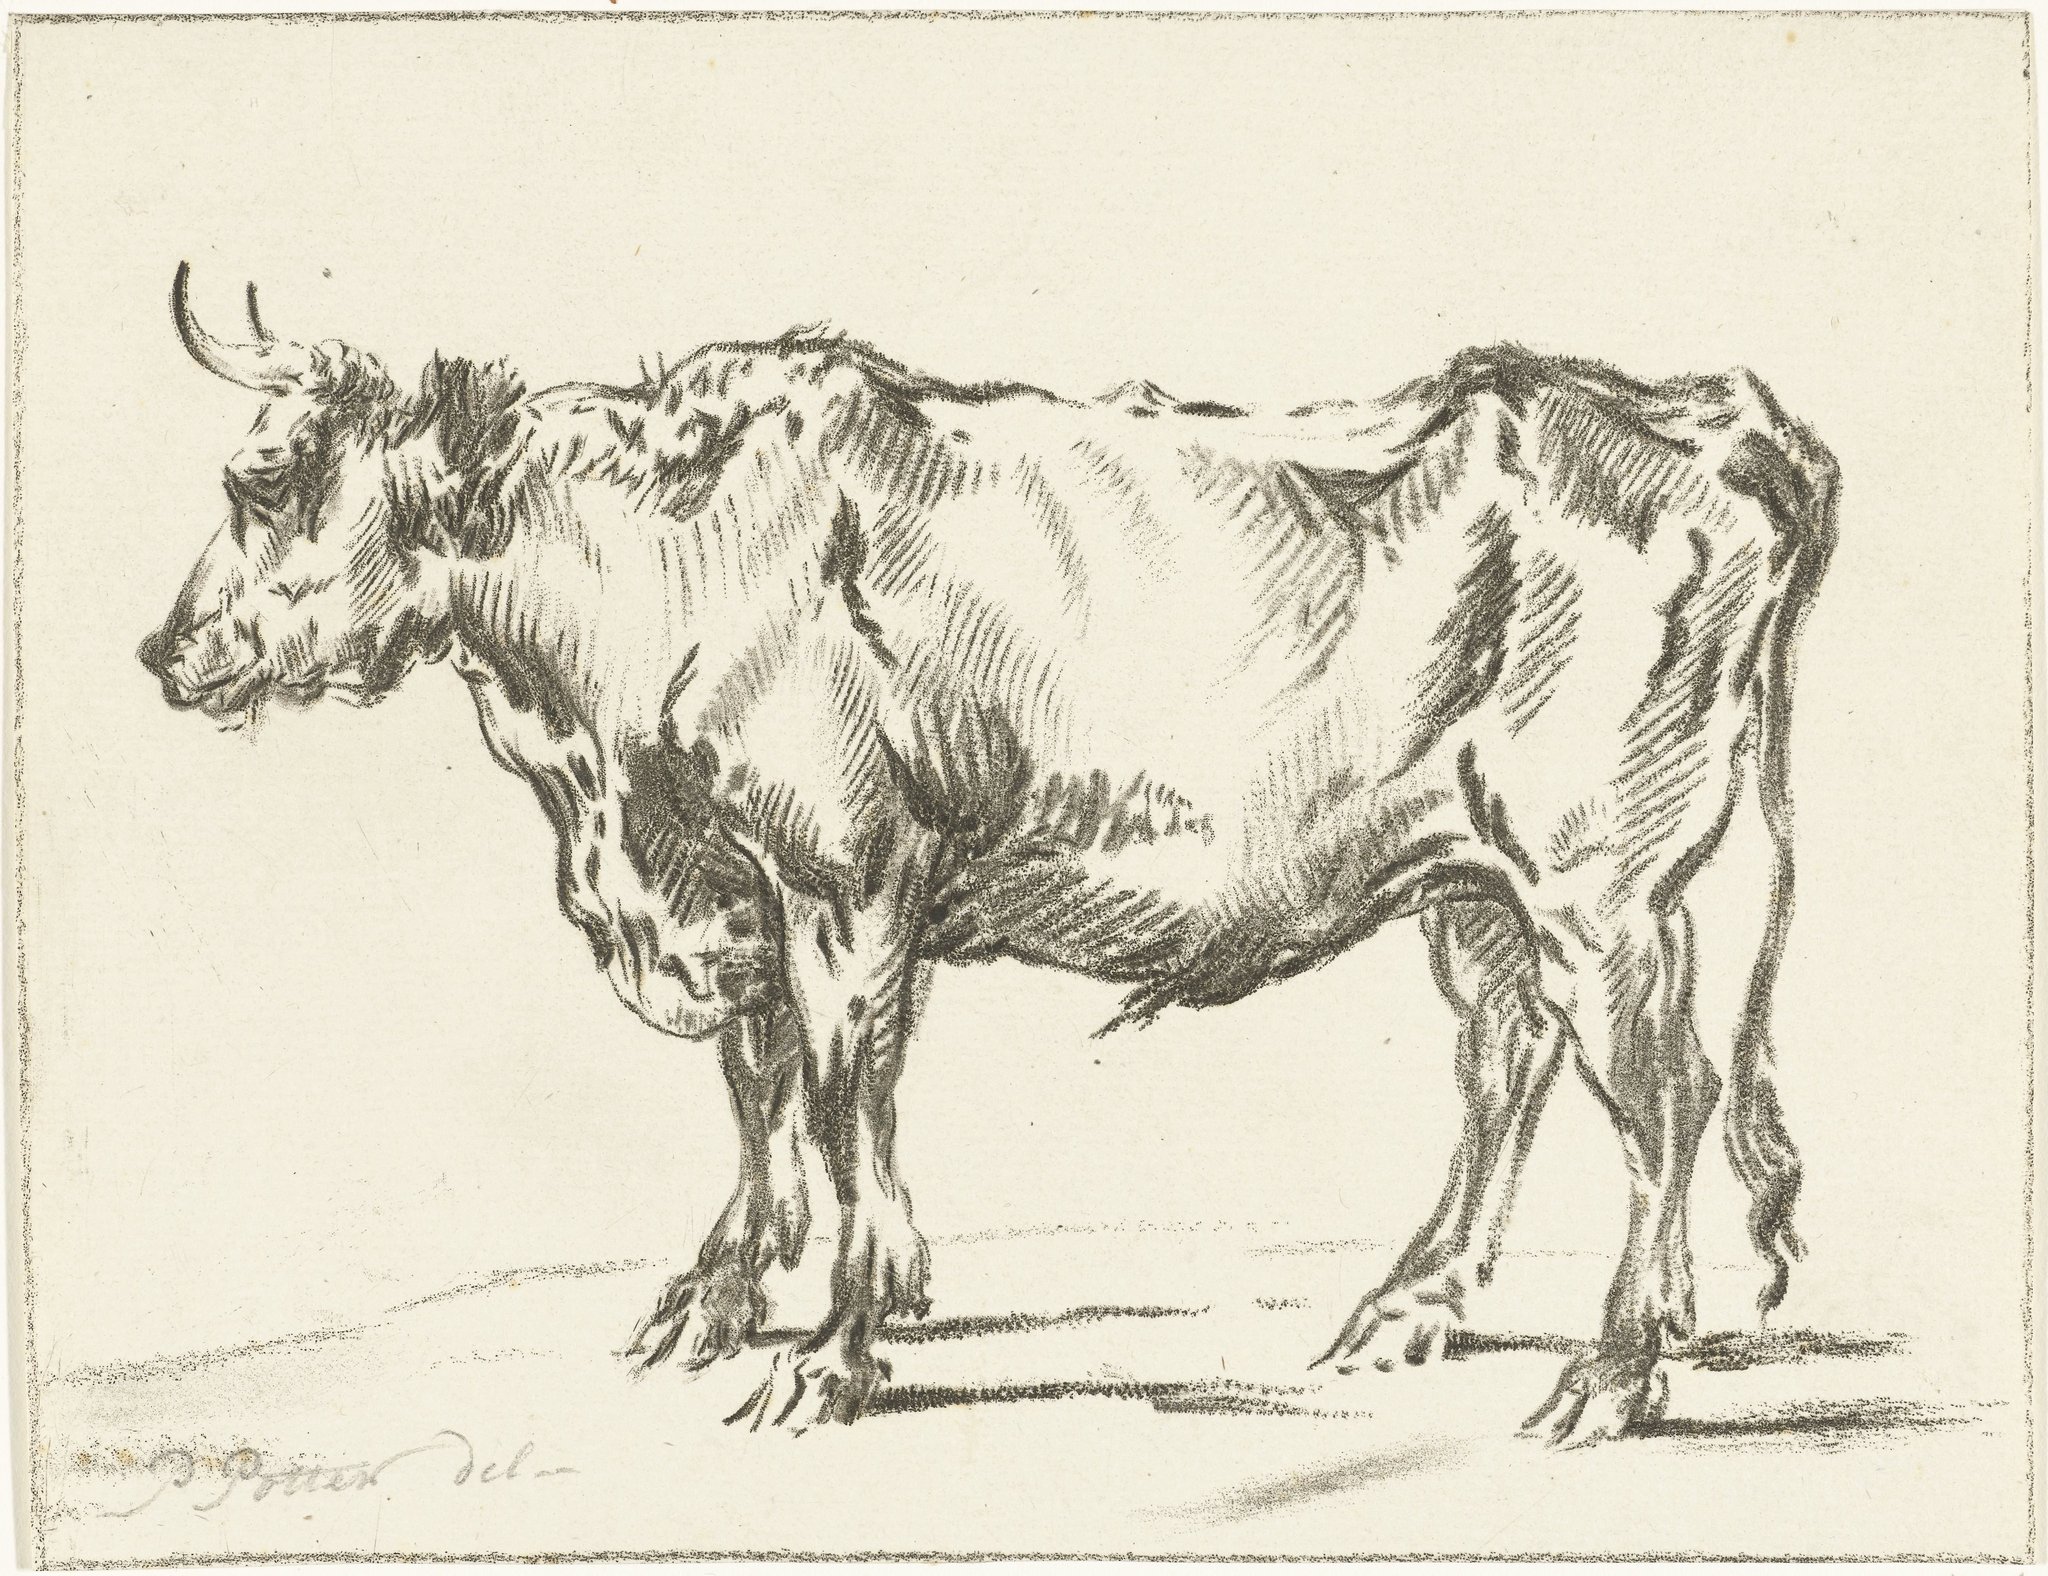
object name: print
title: Staande os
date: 1724-1798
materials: paper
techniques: printmaking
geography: amsterdam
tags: ox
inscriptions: collector's mark: Lugt 240